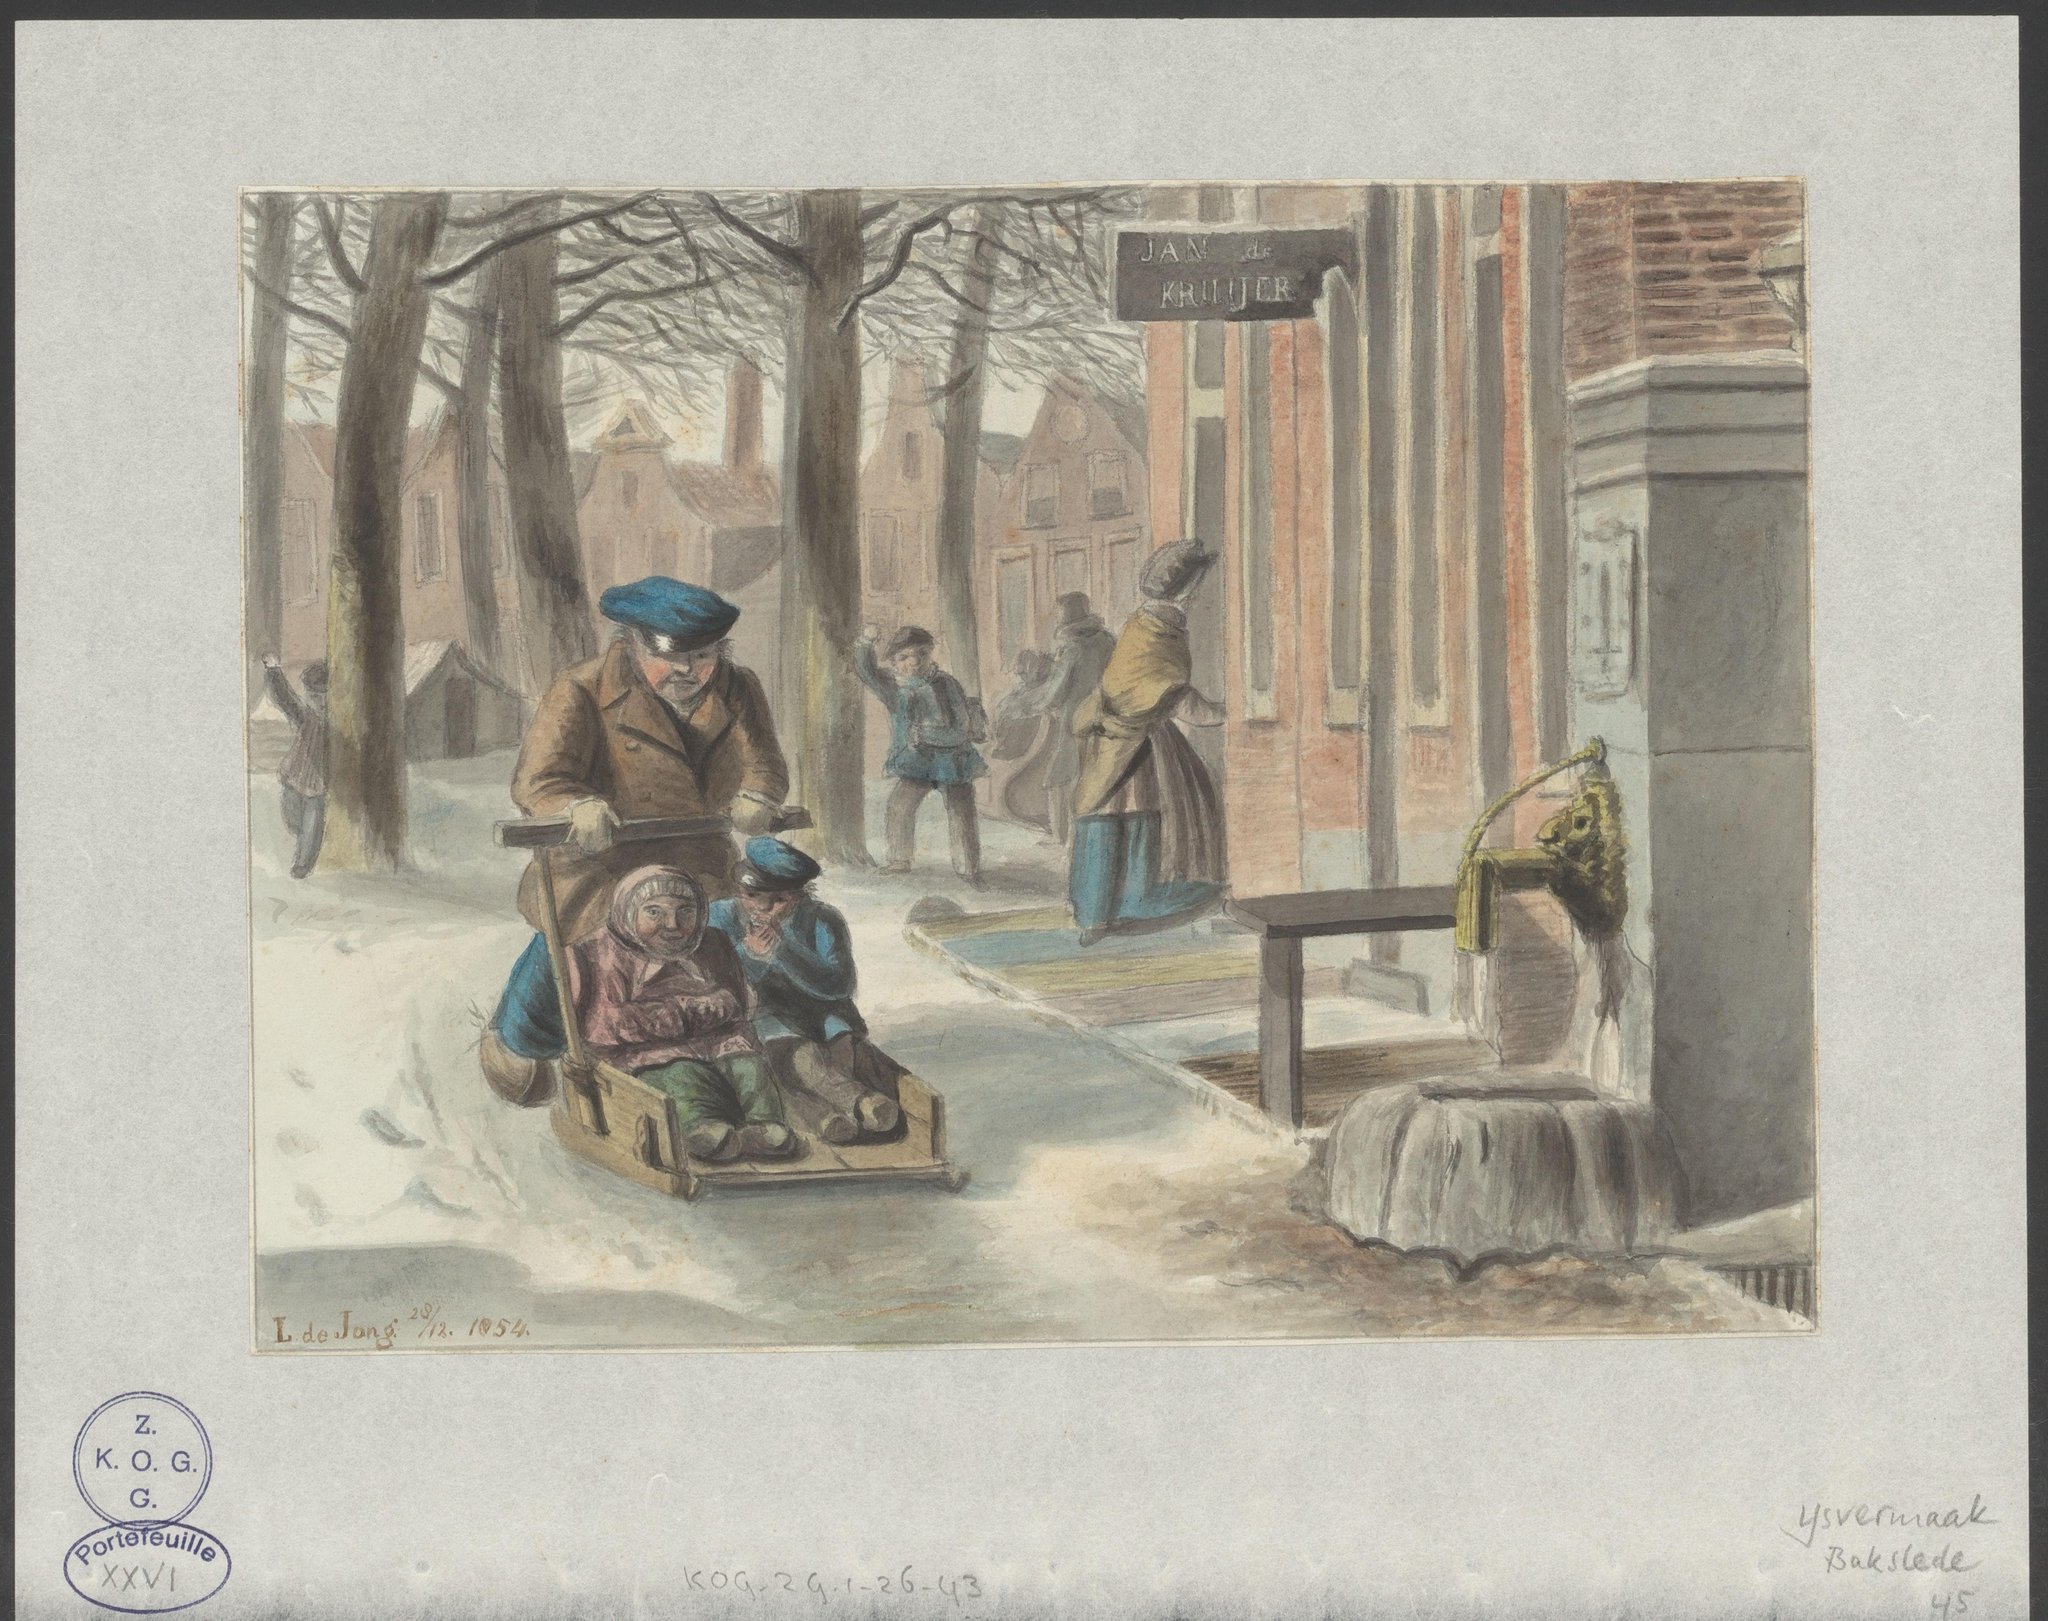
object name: watercolor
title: Stadsgezicht met sneeuwballende jongens en bakslede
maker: lambertus de jong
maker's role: bakker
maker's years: 1838-1923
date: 1854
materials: paper, watercolor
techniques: brush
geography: netherlands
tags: winter sports, sleigh, sledge (non-sport), throwing snowballs, haarlem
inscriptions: collector's mark: Lugt 1641, collector's mark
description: Stadsgezicht met sneeuwballende jongens en een bakslede met twee kinderen geduwd door een man. Rechts een stadspomp met het wapen van Haarlem. Onderwerpsrubrieken binnen de Atlas Zeden en Gewoonten: Spel en Vermaak; IJsvermaak, Sleden.